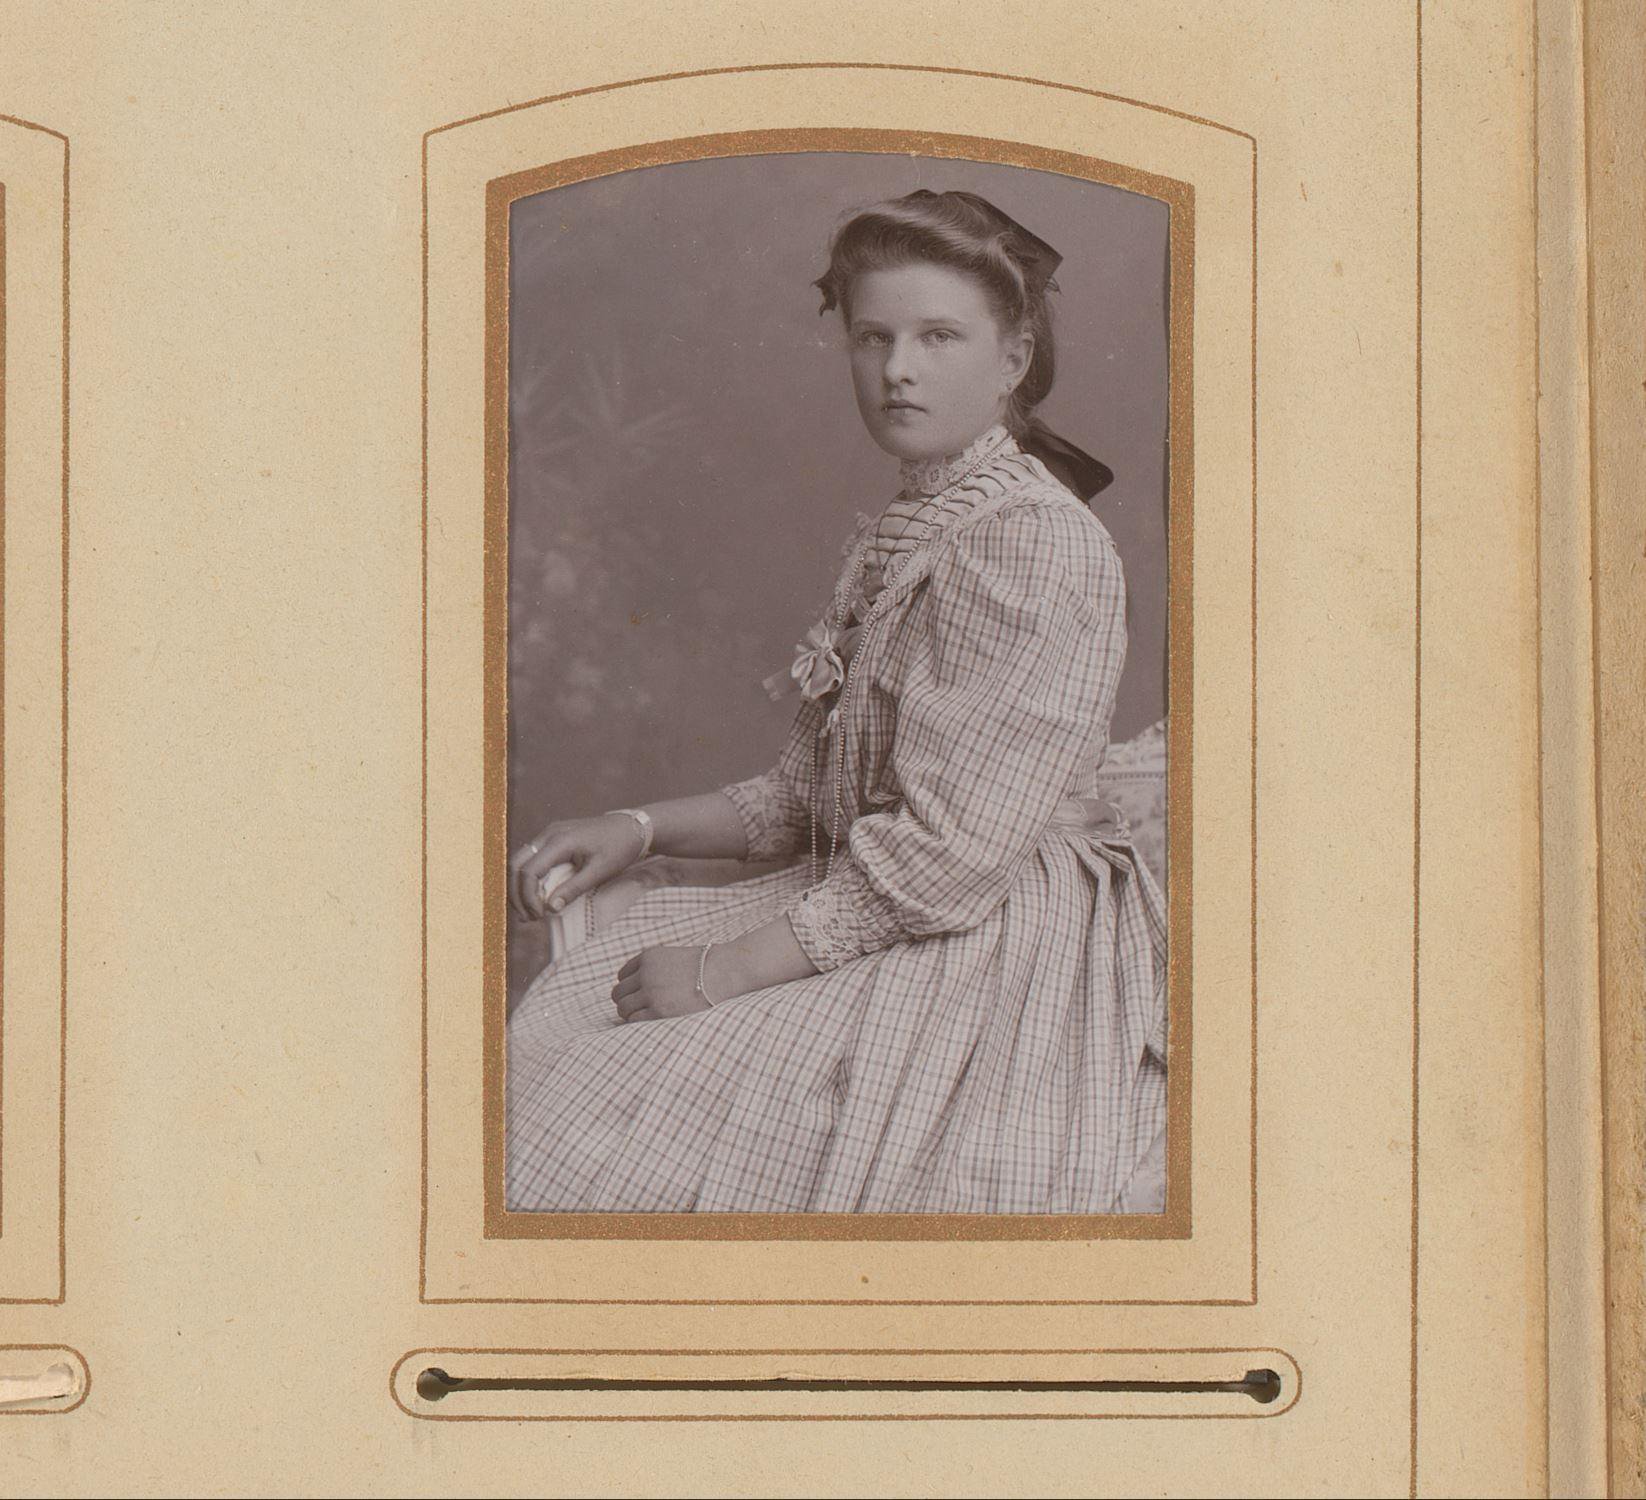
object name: album leaf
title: Portret van een zittend meisje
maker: berend zweers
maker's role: fotograaf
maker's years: 1872-1946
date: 1923-1934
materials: cardboard, photographic support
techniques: collodion silver print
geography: haarlem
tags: girl (child between toddler and youth)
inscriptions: inscription: ‘B. Zweers/ 174 Groote Houtstraat 174/ Haarlem’